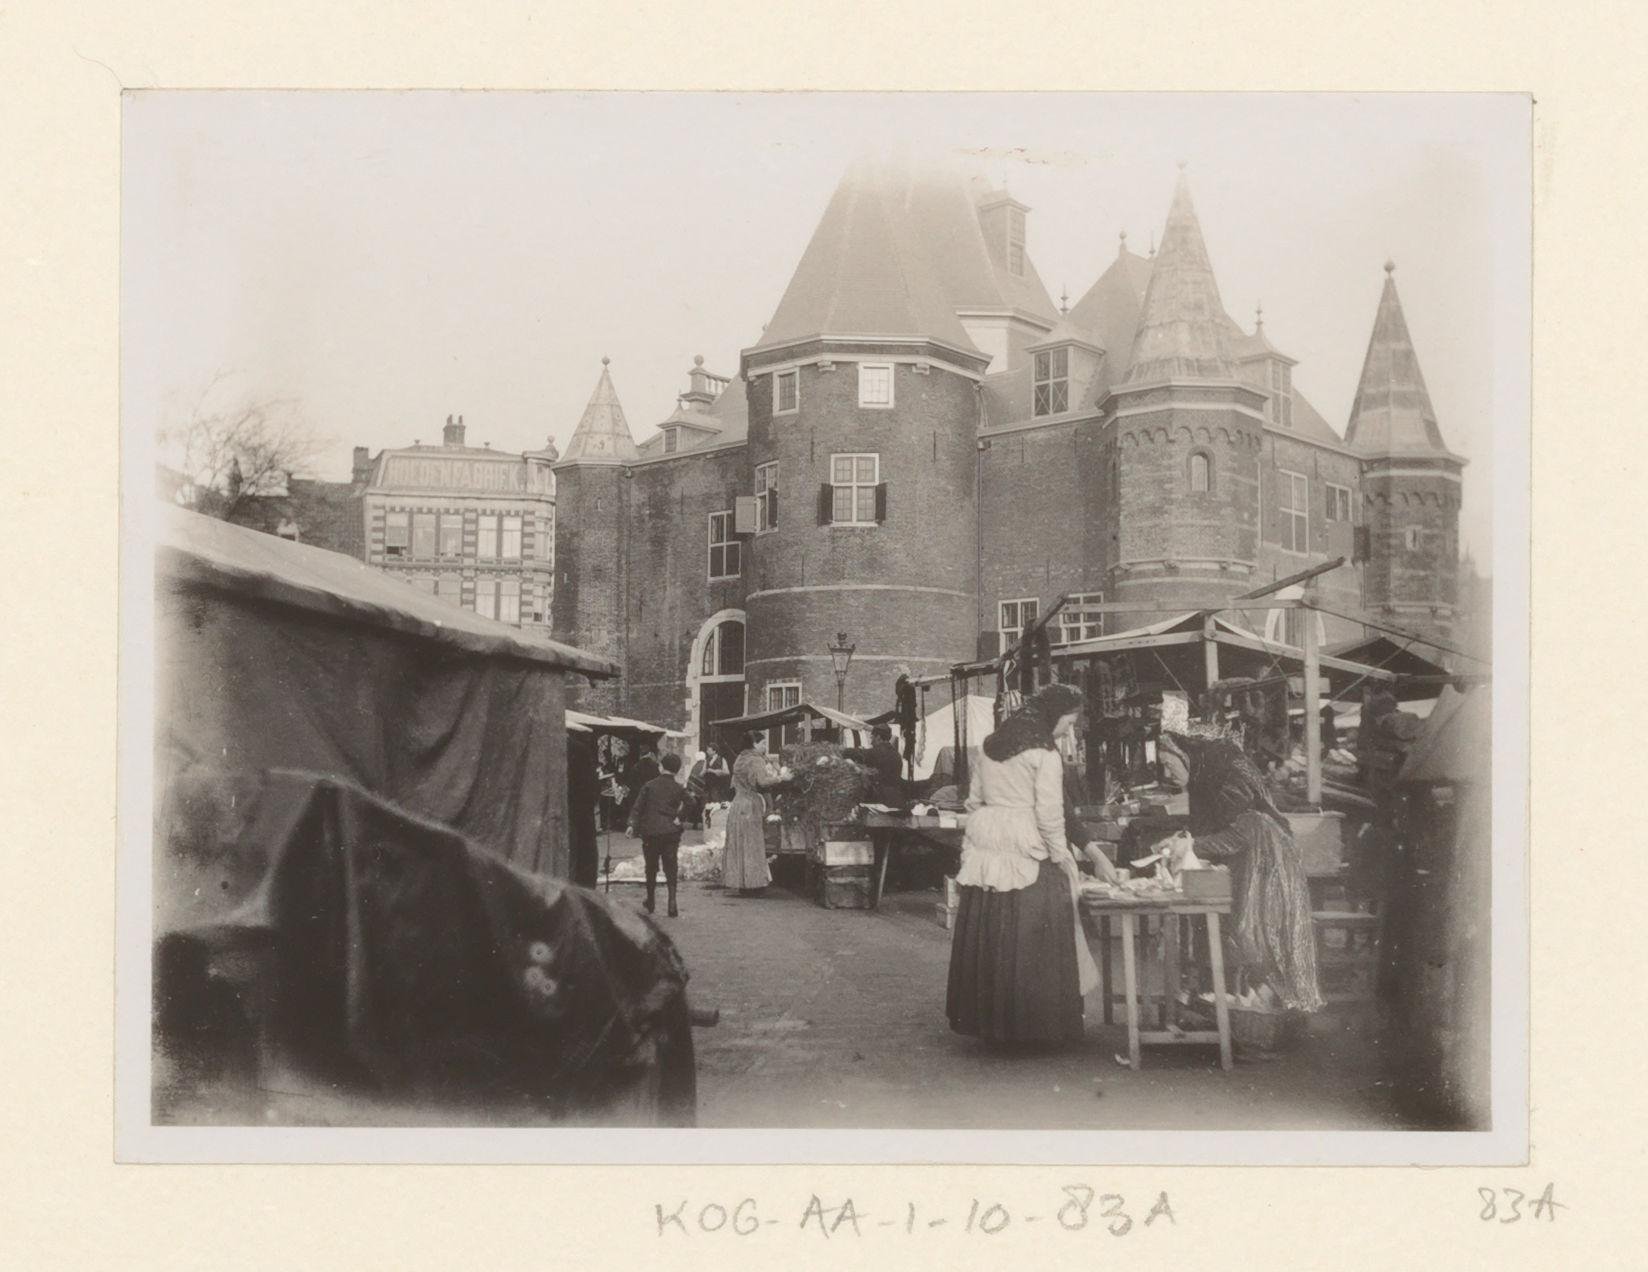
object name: photograph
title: Gezicht op de markt op de Nieuwmarkt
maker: Anonymous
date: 1880-1950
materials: paper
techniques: gelatin silver print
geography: amsterdam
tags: square, place, circus, etc., city-view in general; 'veduta', stall, booth (~ market), market, weigh-house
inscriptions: collector's mark: ‘10,83 A/B’ Lugt 1641b, inscription: ‘Nieuwmarkt met Waag’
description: Onderwerpsrubriek binnen de Atlas Amsterdam: Nieuwmarkt, Noordermarkt.